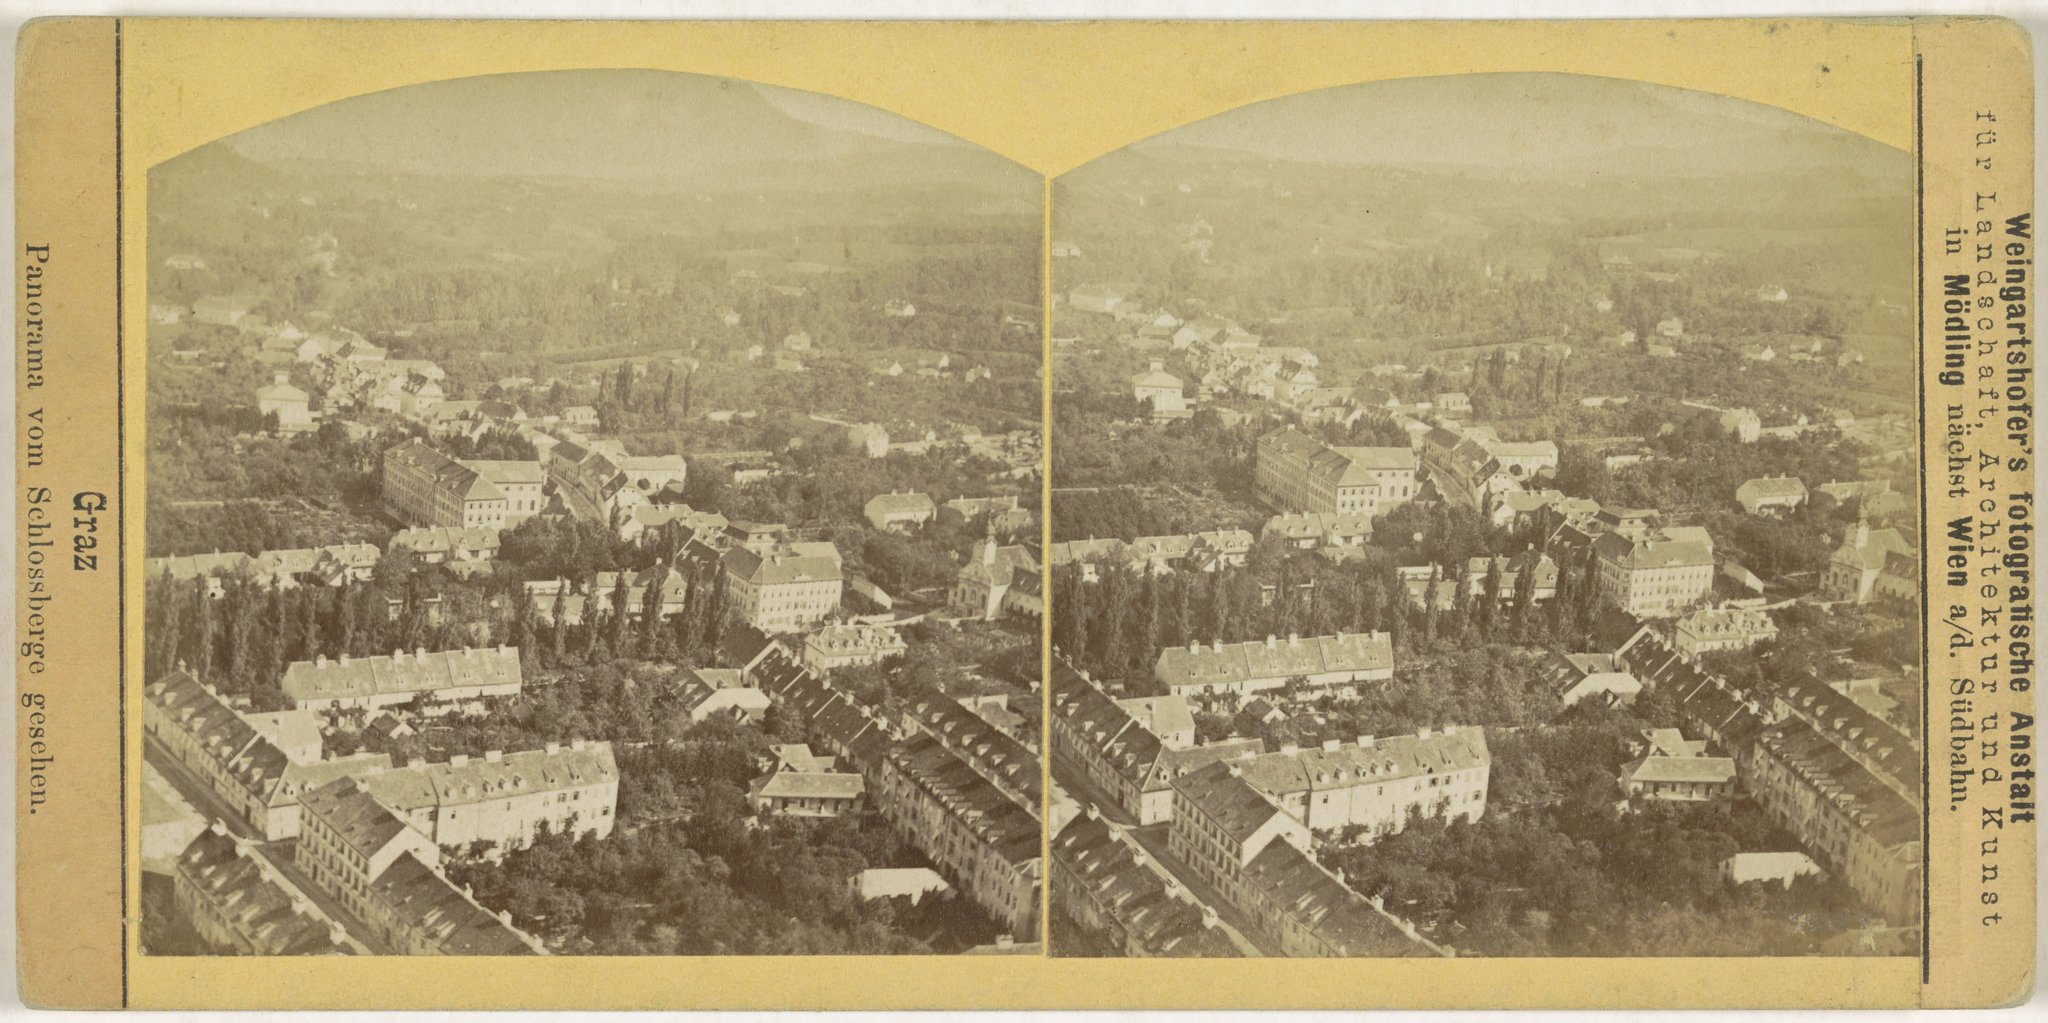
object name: stereograph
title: Gezicht op Graz, gezien vanaf de Schlossberg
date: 1857-1863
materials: cardboard, paper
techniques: albumen print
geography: graz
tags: city-view in general; 'veduta'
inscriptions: inscription: ‘30_’